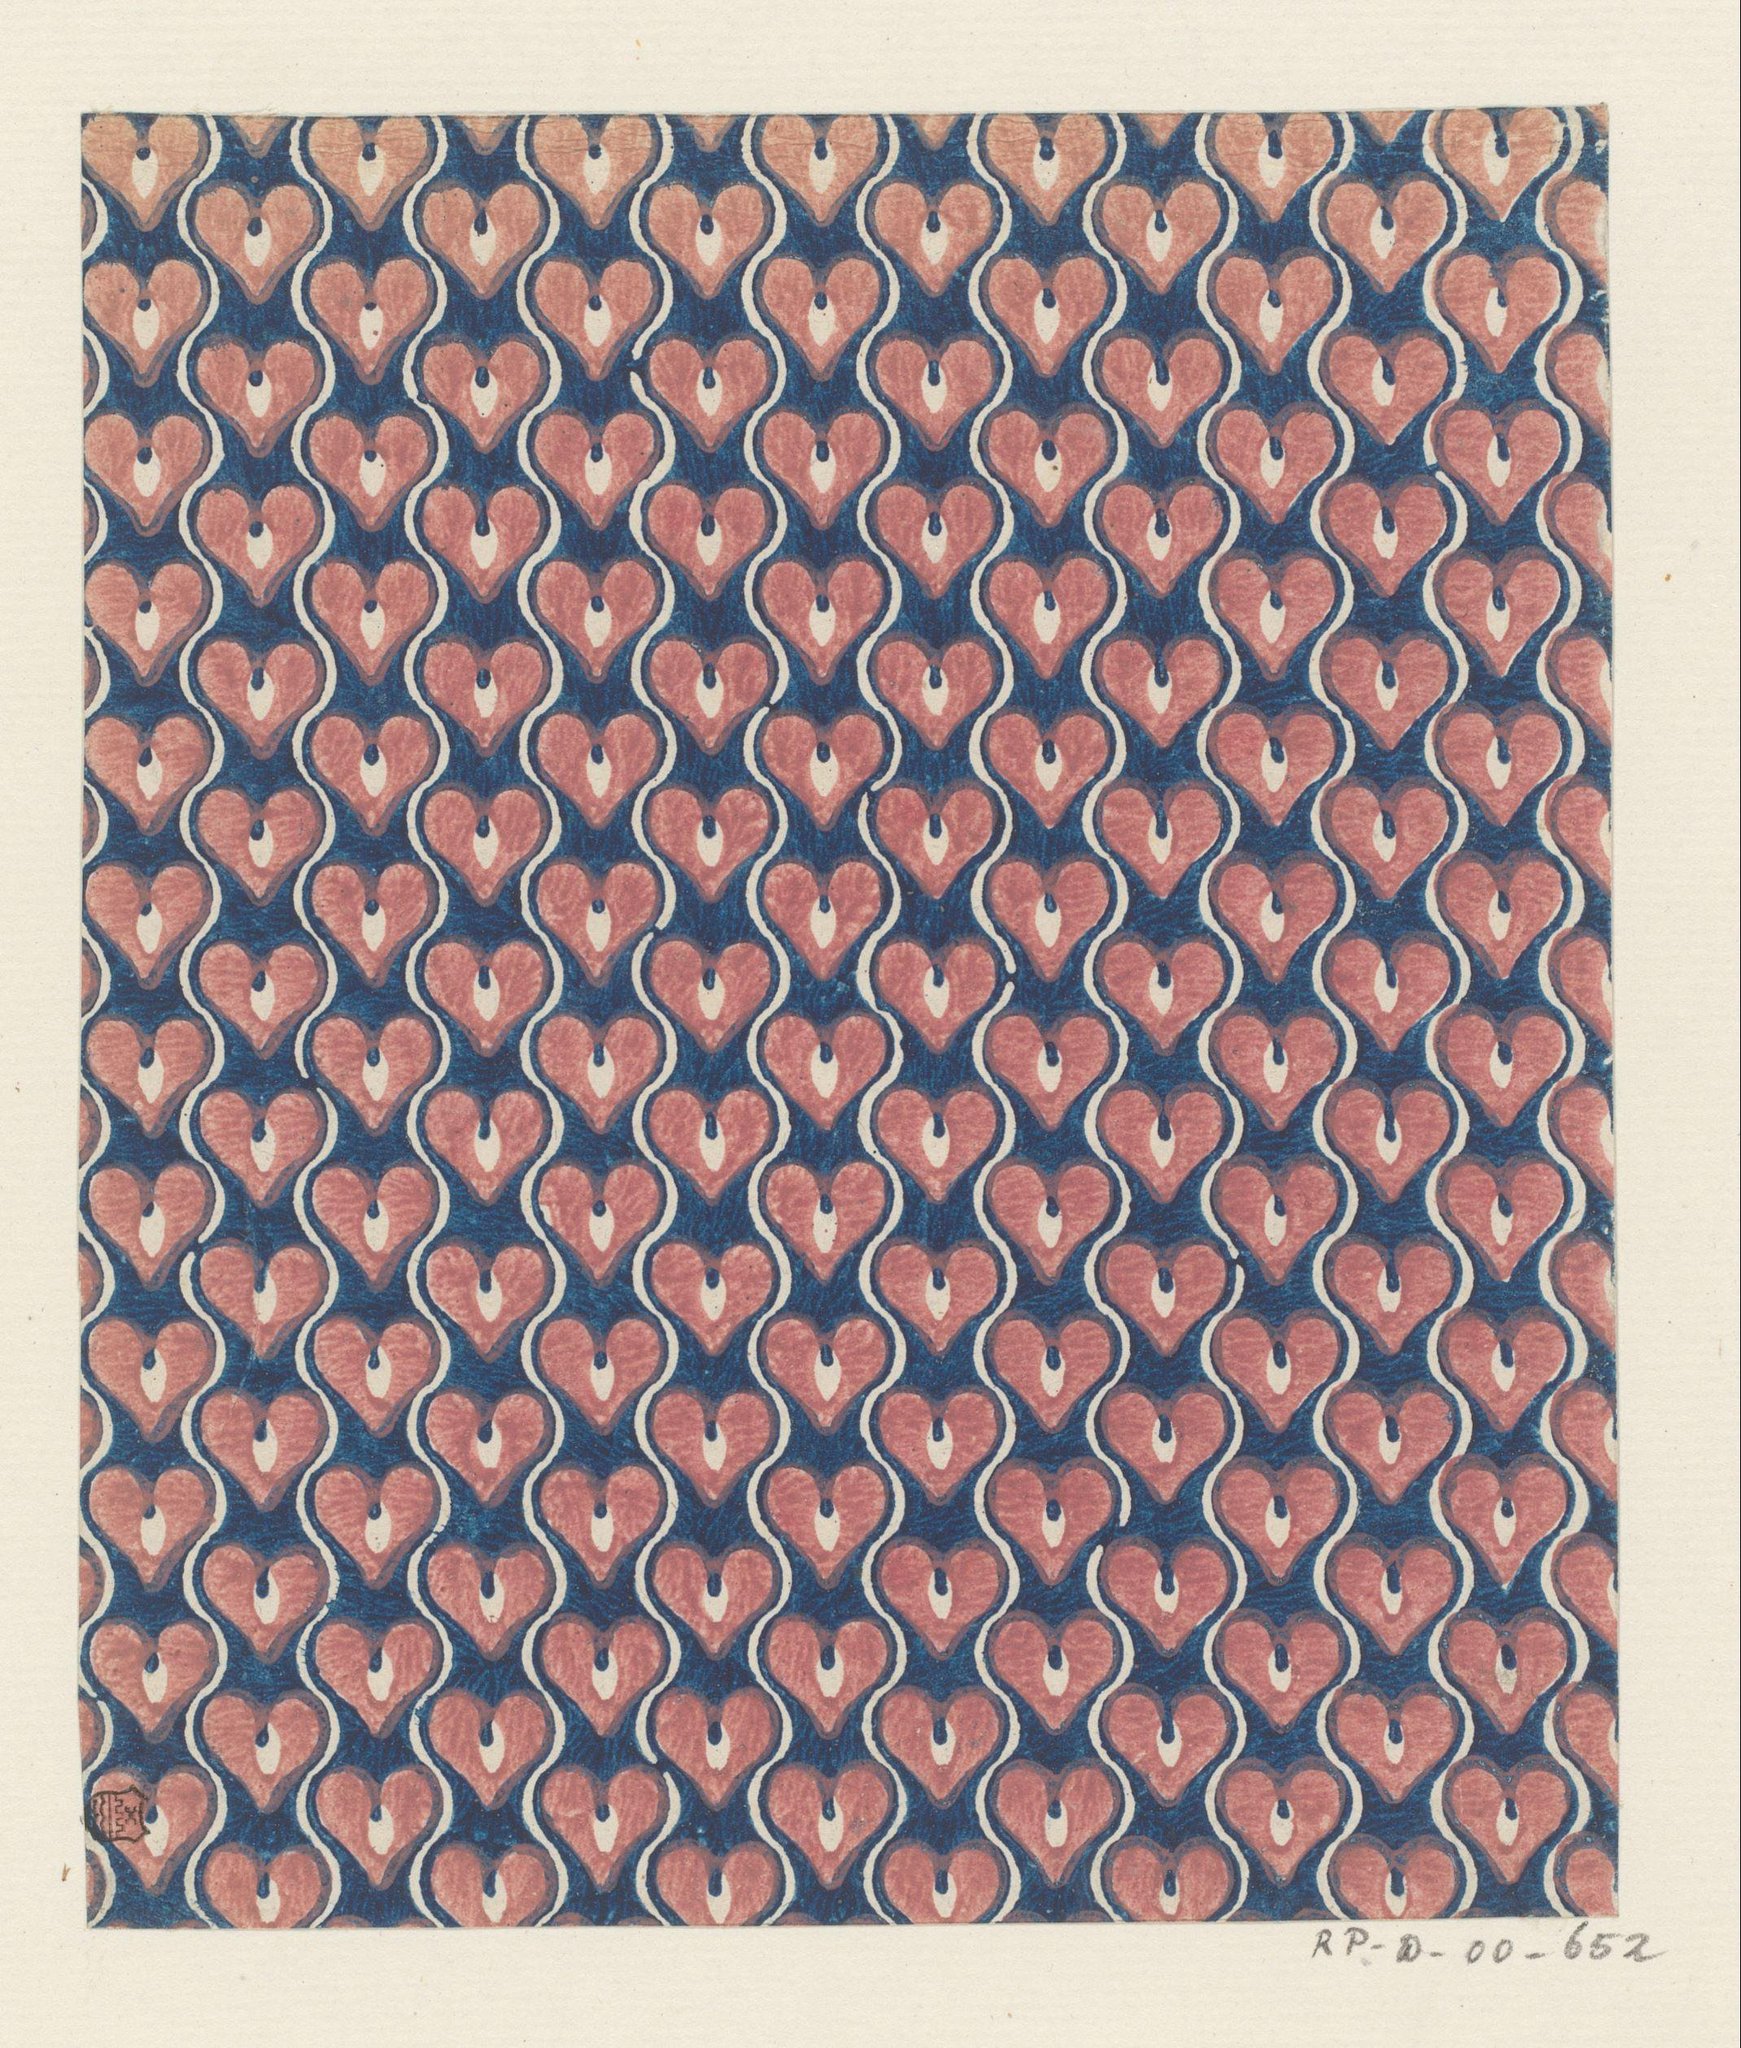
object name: printed paper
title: Blad met banenpatroon van harten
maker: Anonymous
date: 1750-1900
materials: paper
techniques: printing block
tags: ornament derived from objects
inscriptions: collector's mark: Lugt 2760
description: Blad met banenpatroon van verticale slingerende banen met harten.